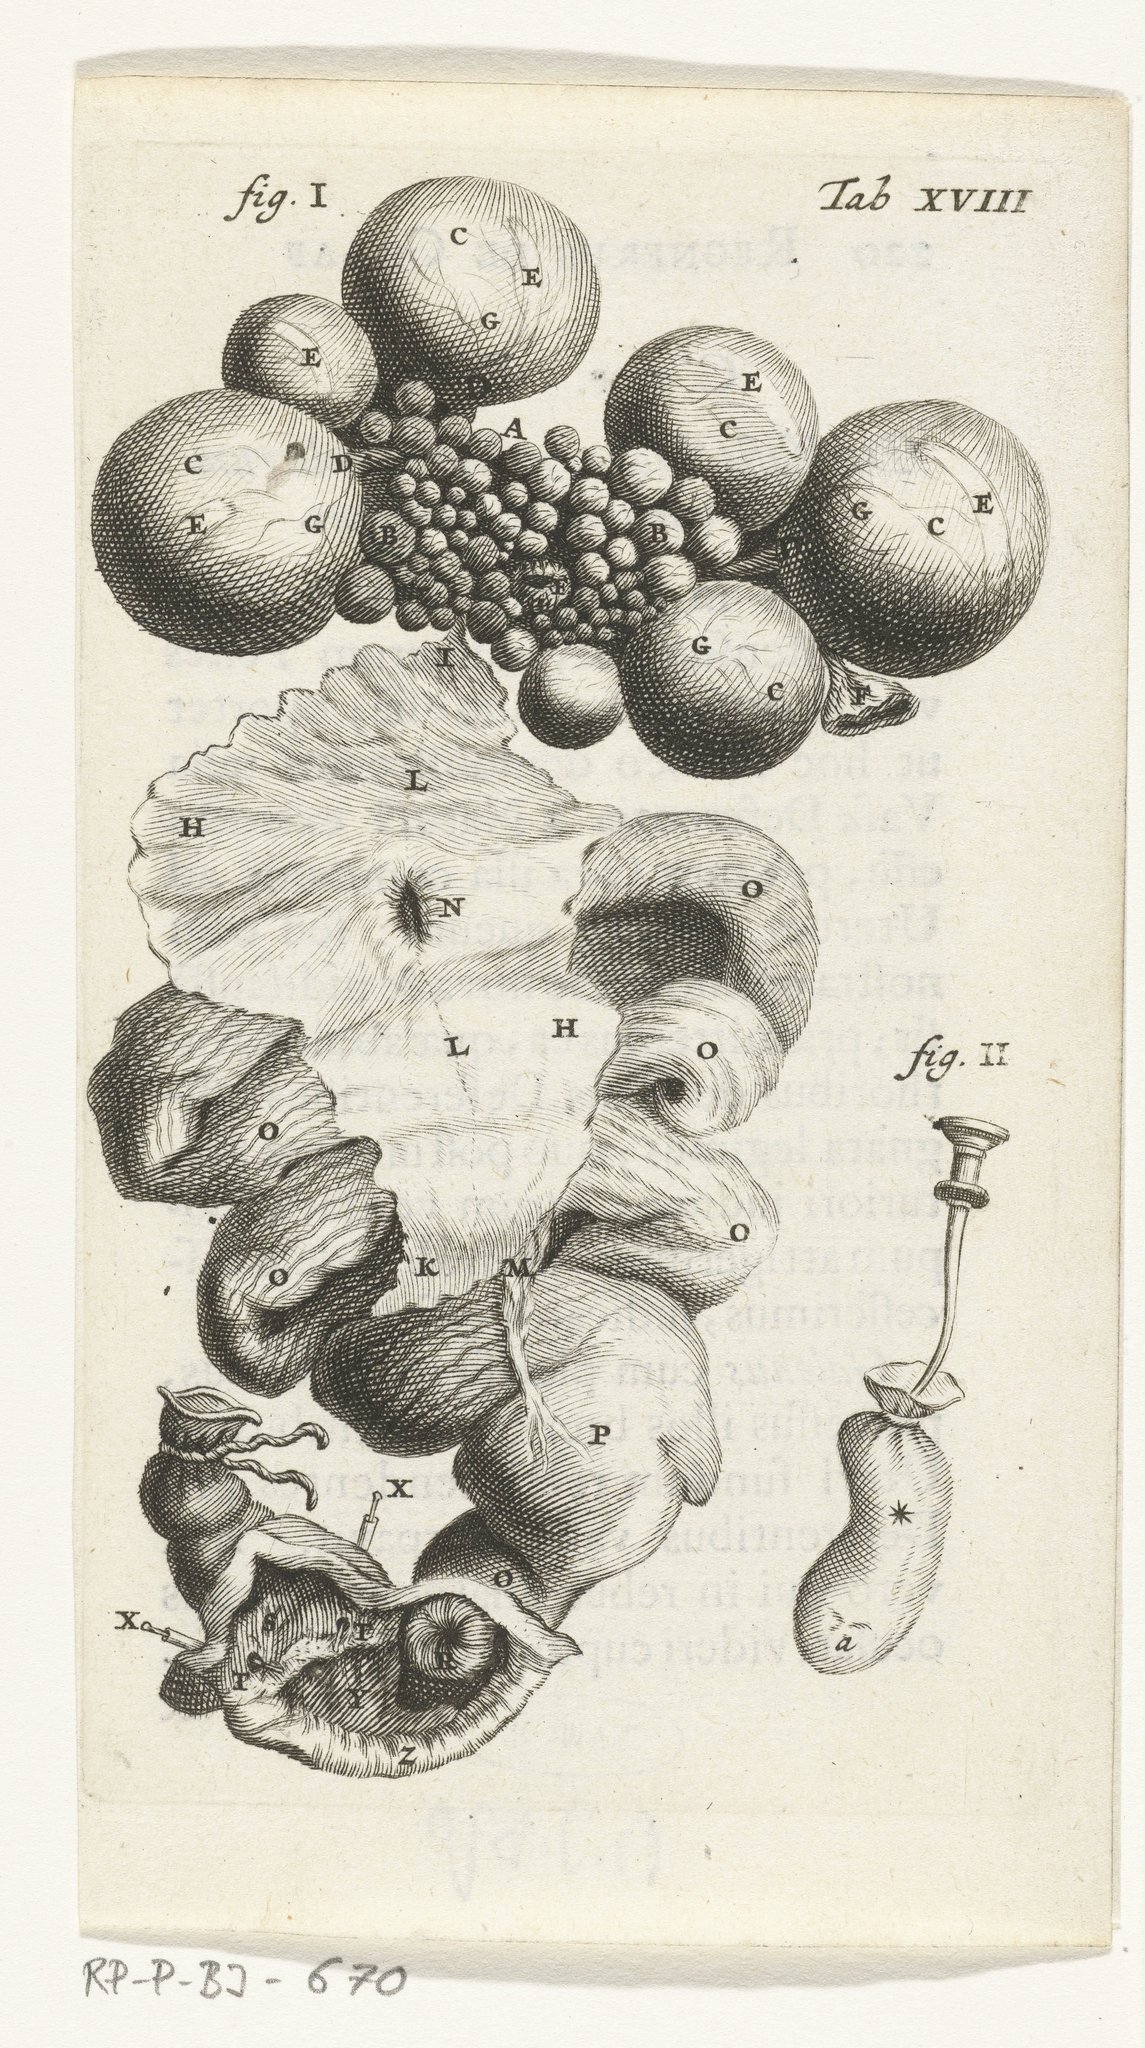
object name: book illustration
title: Prints of the Female Reproductive Organs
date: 1672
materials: paper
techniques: engraving, letterpress printing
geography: leiden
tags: female sexual organs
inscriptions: collector's mark: Lugt 2228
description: In 1672, physician and anatomist Reinier de Graaf published his De mulierum organis about the female reproductive organs. The book contains detailed prints by Hendrik Bary, among them several of the vagina. De Graaf was the first to conclude that a foetus was the product not just of a man’s seed, but also of a woman’s egg. He discovered what he called blisters, which later became known as Graafian follicles.